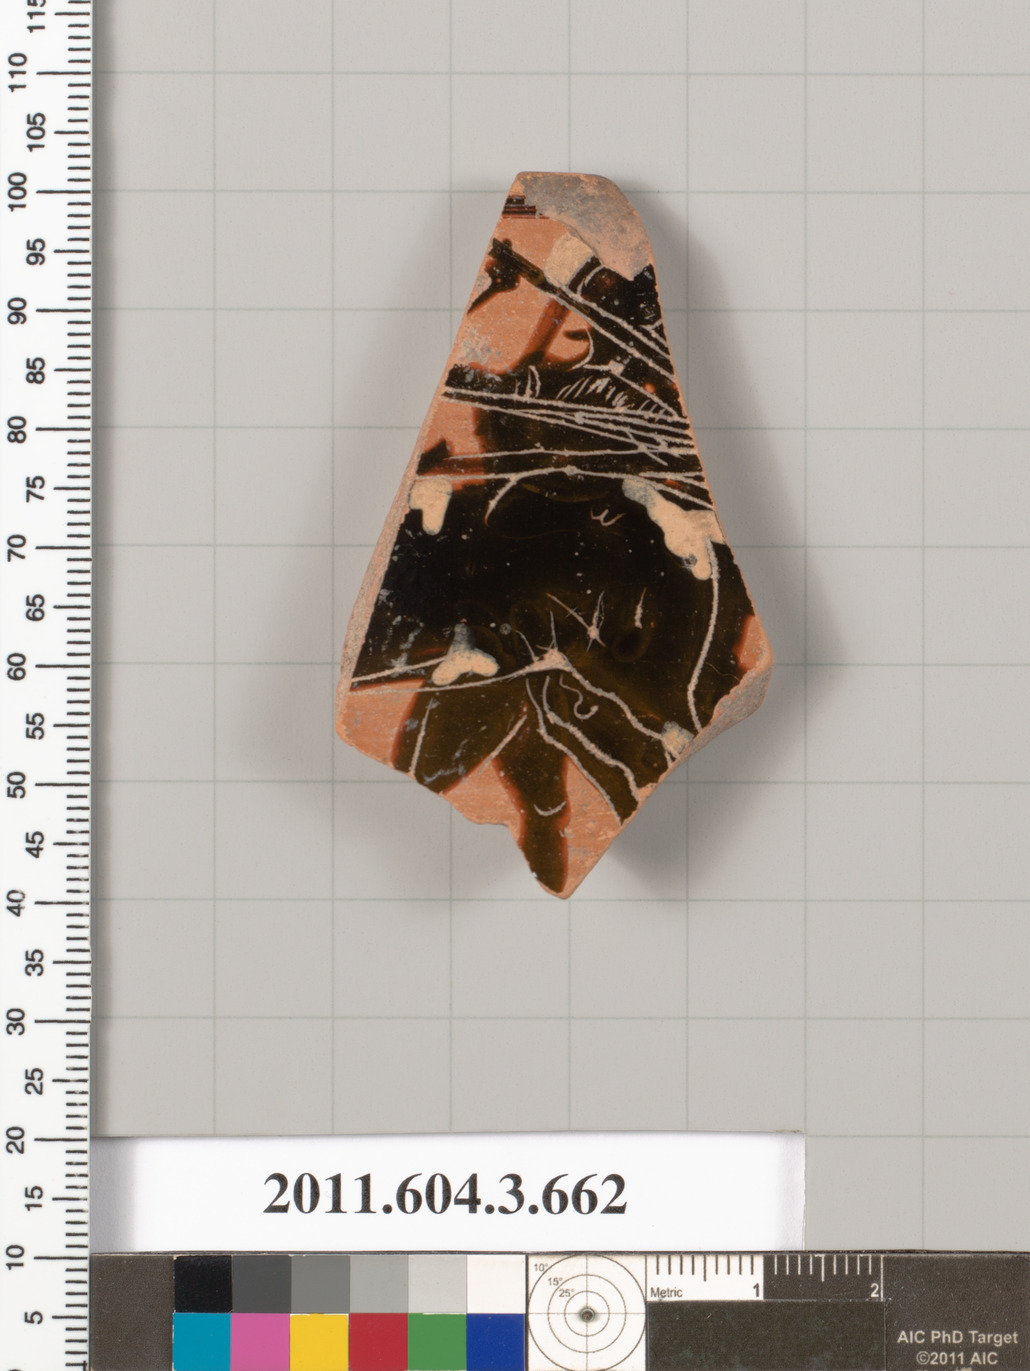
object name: volute krater fragment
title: Terracotta fragment of a volute-krater (bowl for mixing wine and water)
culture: greek, attic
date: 534-468 BCE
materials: terracotta